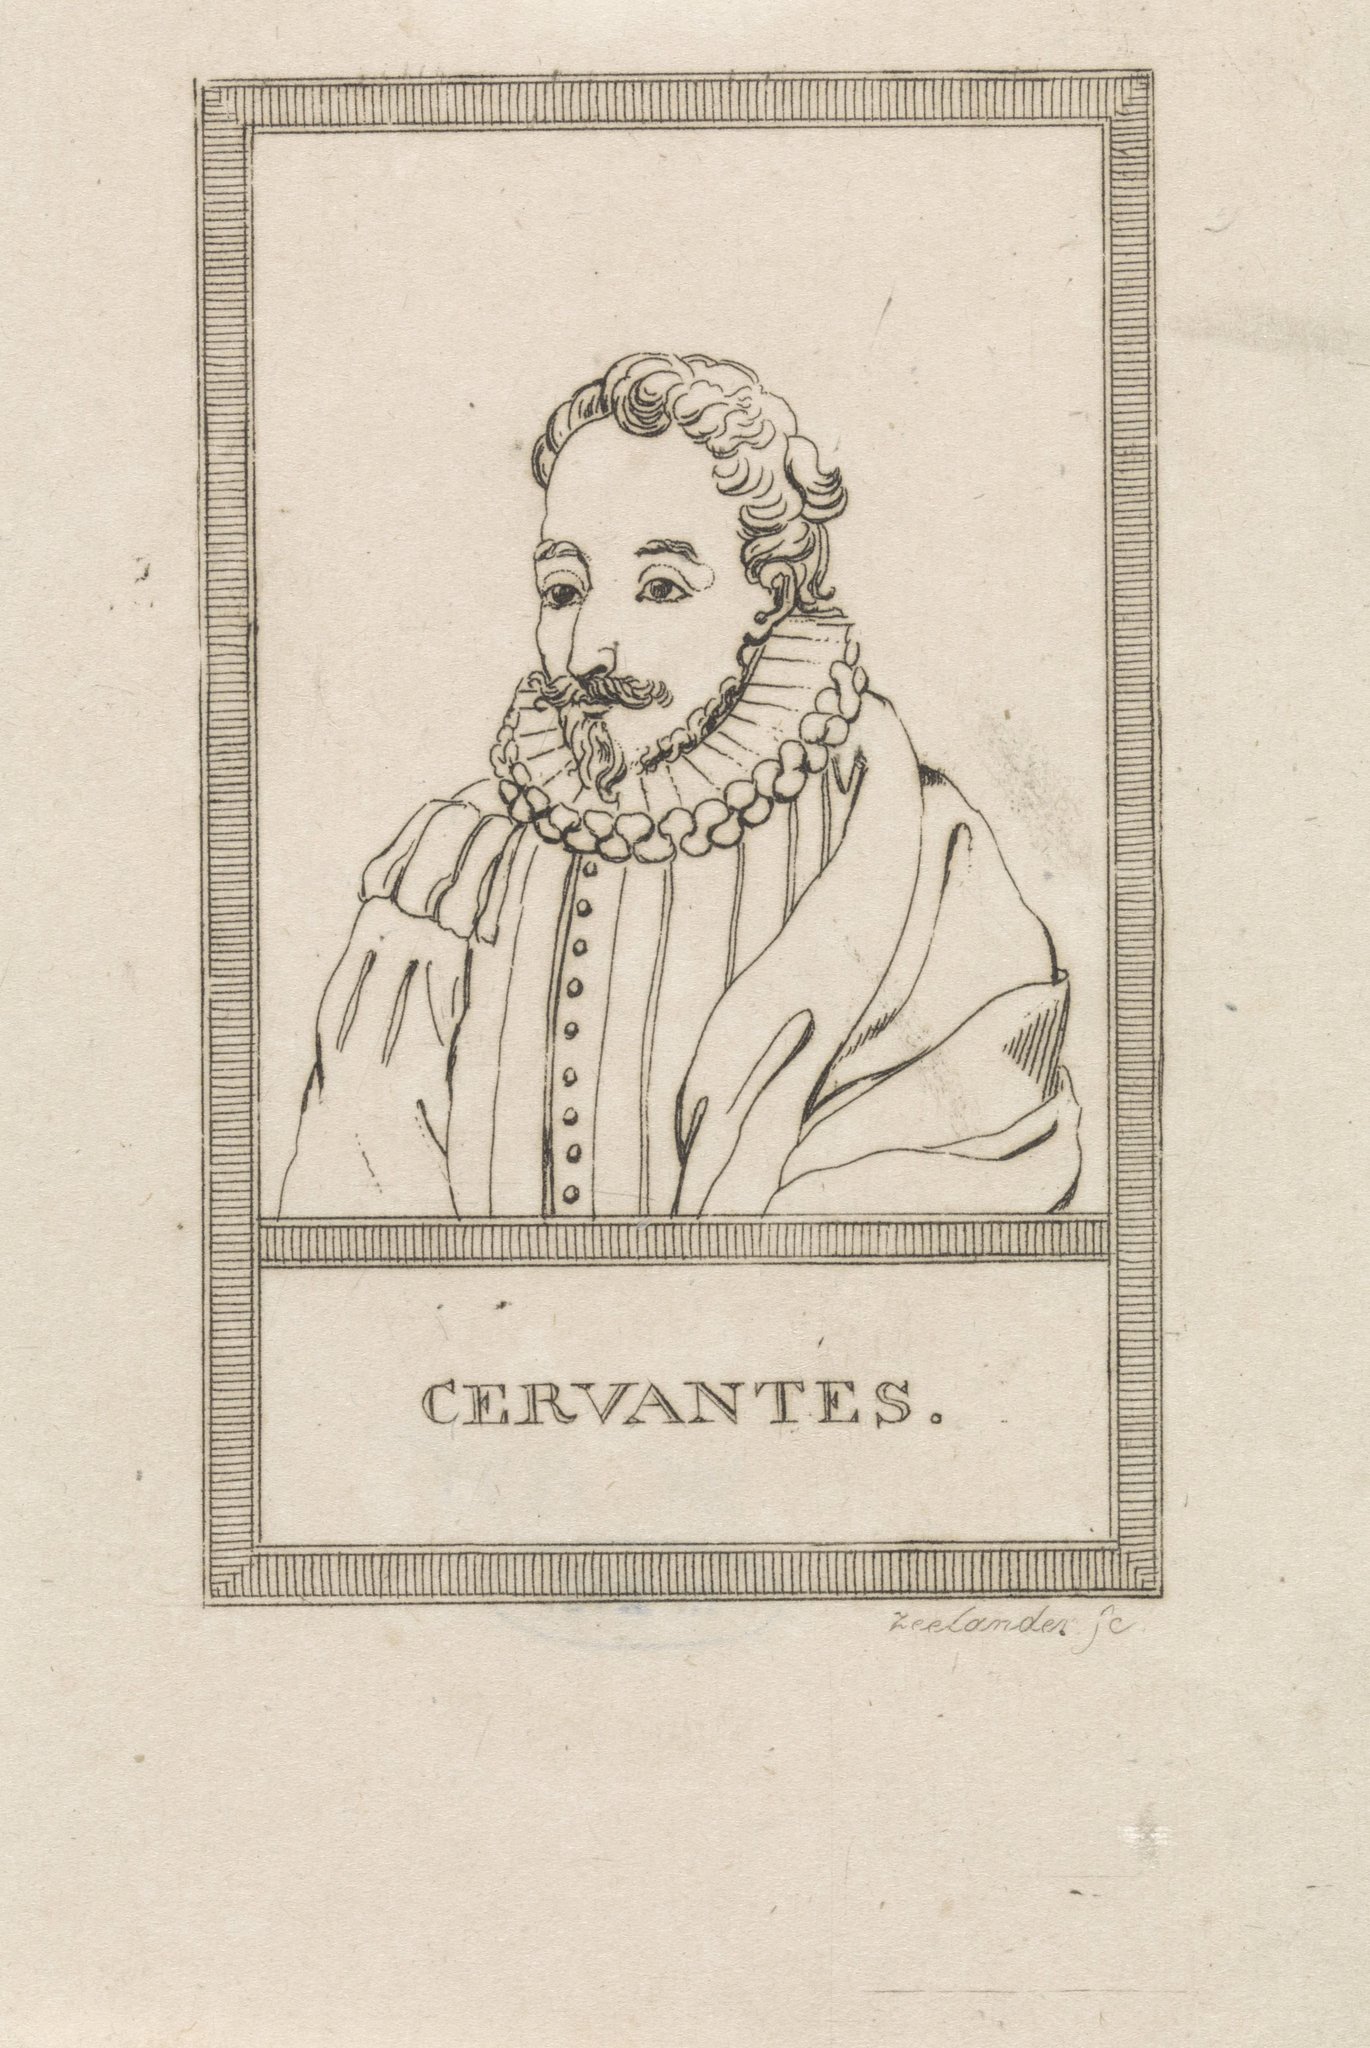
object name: print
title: Portret van Spaans schrijver Miguel de Cervantes Saavedra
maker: abraham lion zeelander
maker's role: draughtsman, print maker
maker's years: 1789-1856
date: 1799-1856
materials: paper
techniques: etching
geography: amsterdam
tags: schrijver, miguel de cervantes saavedra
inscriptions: collector's mark: Lugt 2228